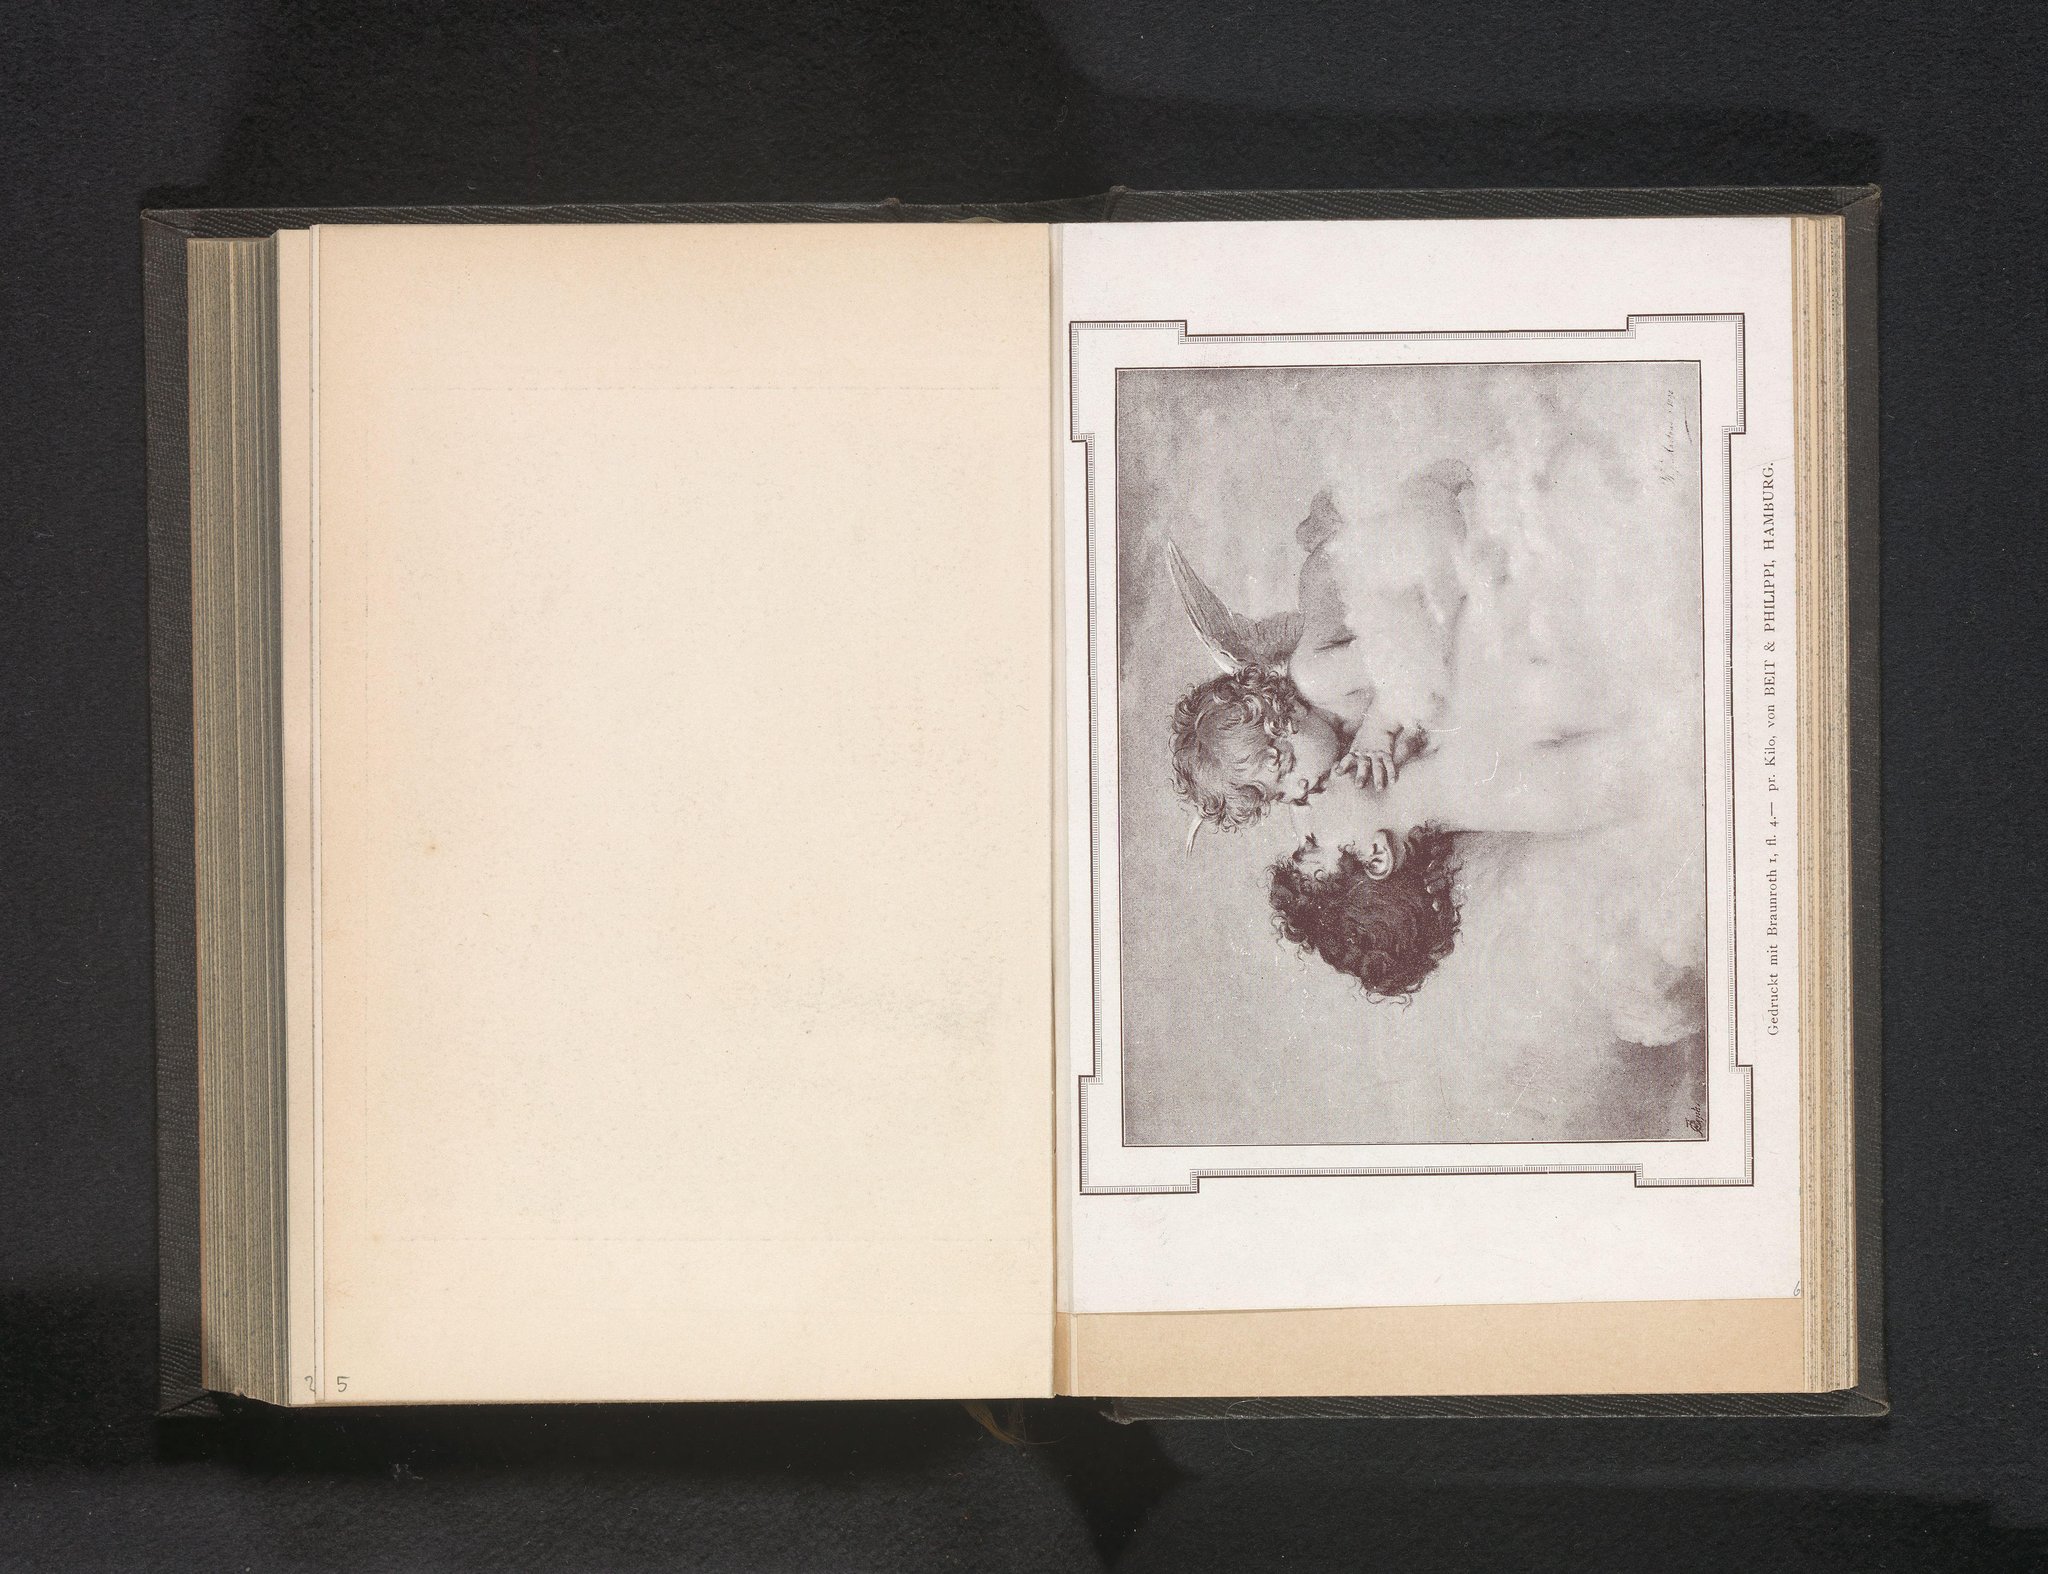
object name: page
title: Reproductie van een ontwerp van een engel die een man kust tussen de wolken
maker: Anonymous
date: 1887-1892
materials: paper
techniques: color autotype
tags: cherubs, i.e. children's heads with wings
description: Prent op elfde ongenummerde pagina na pagina 520.